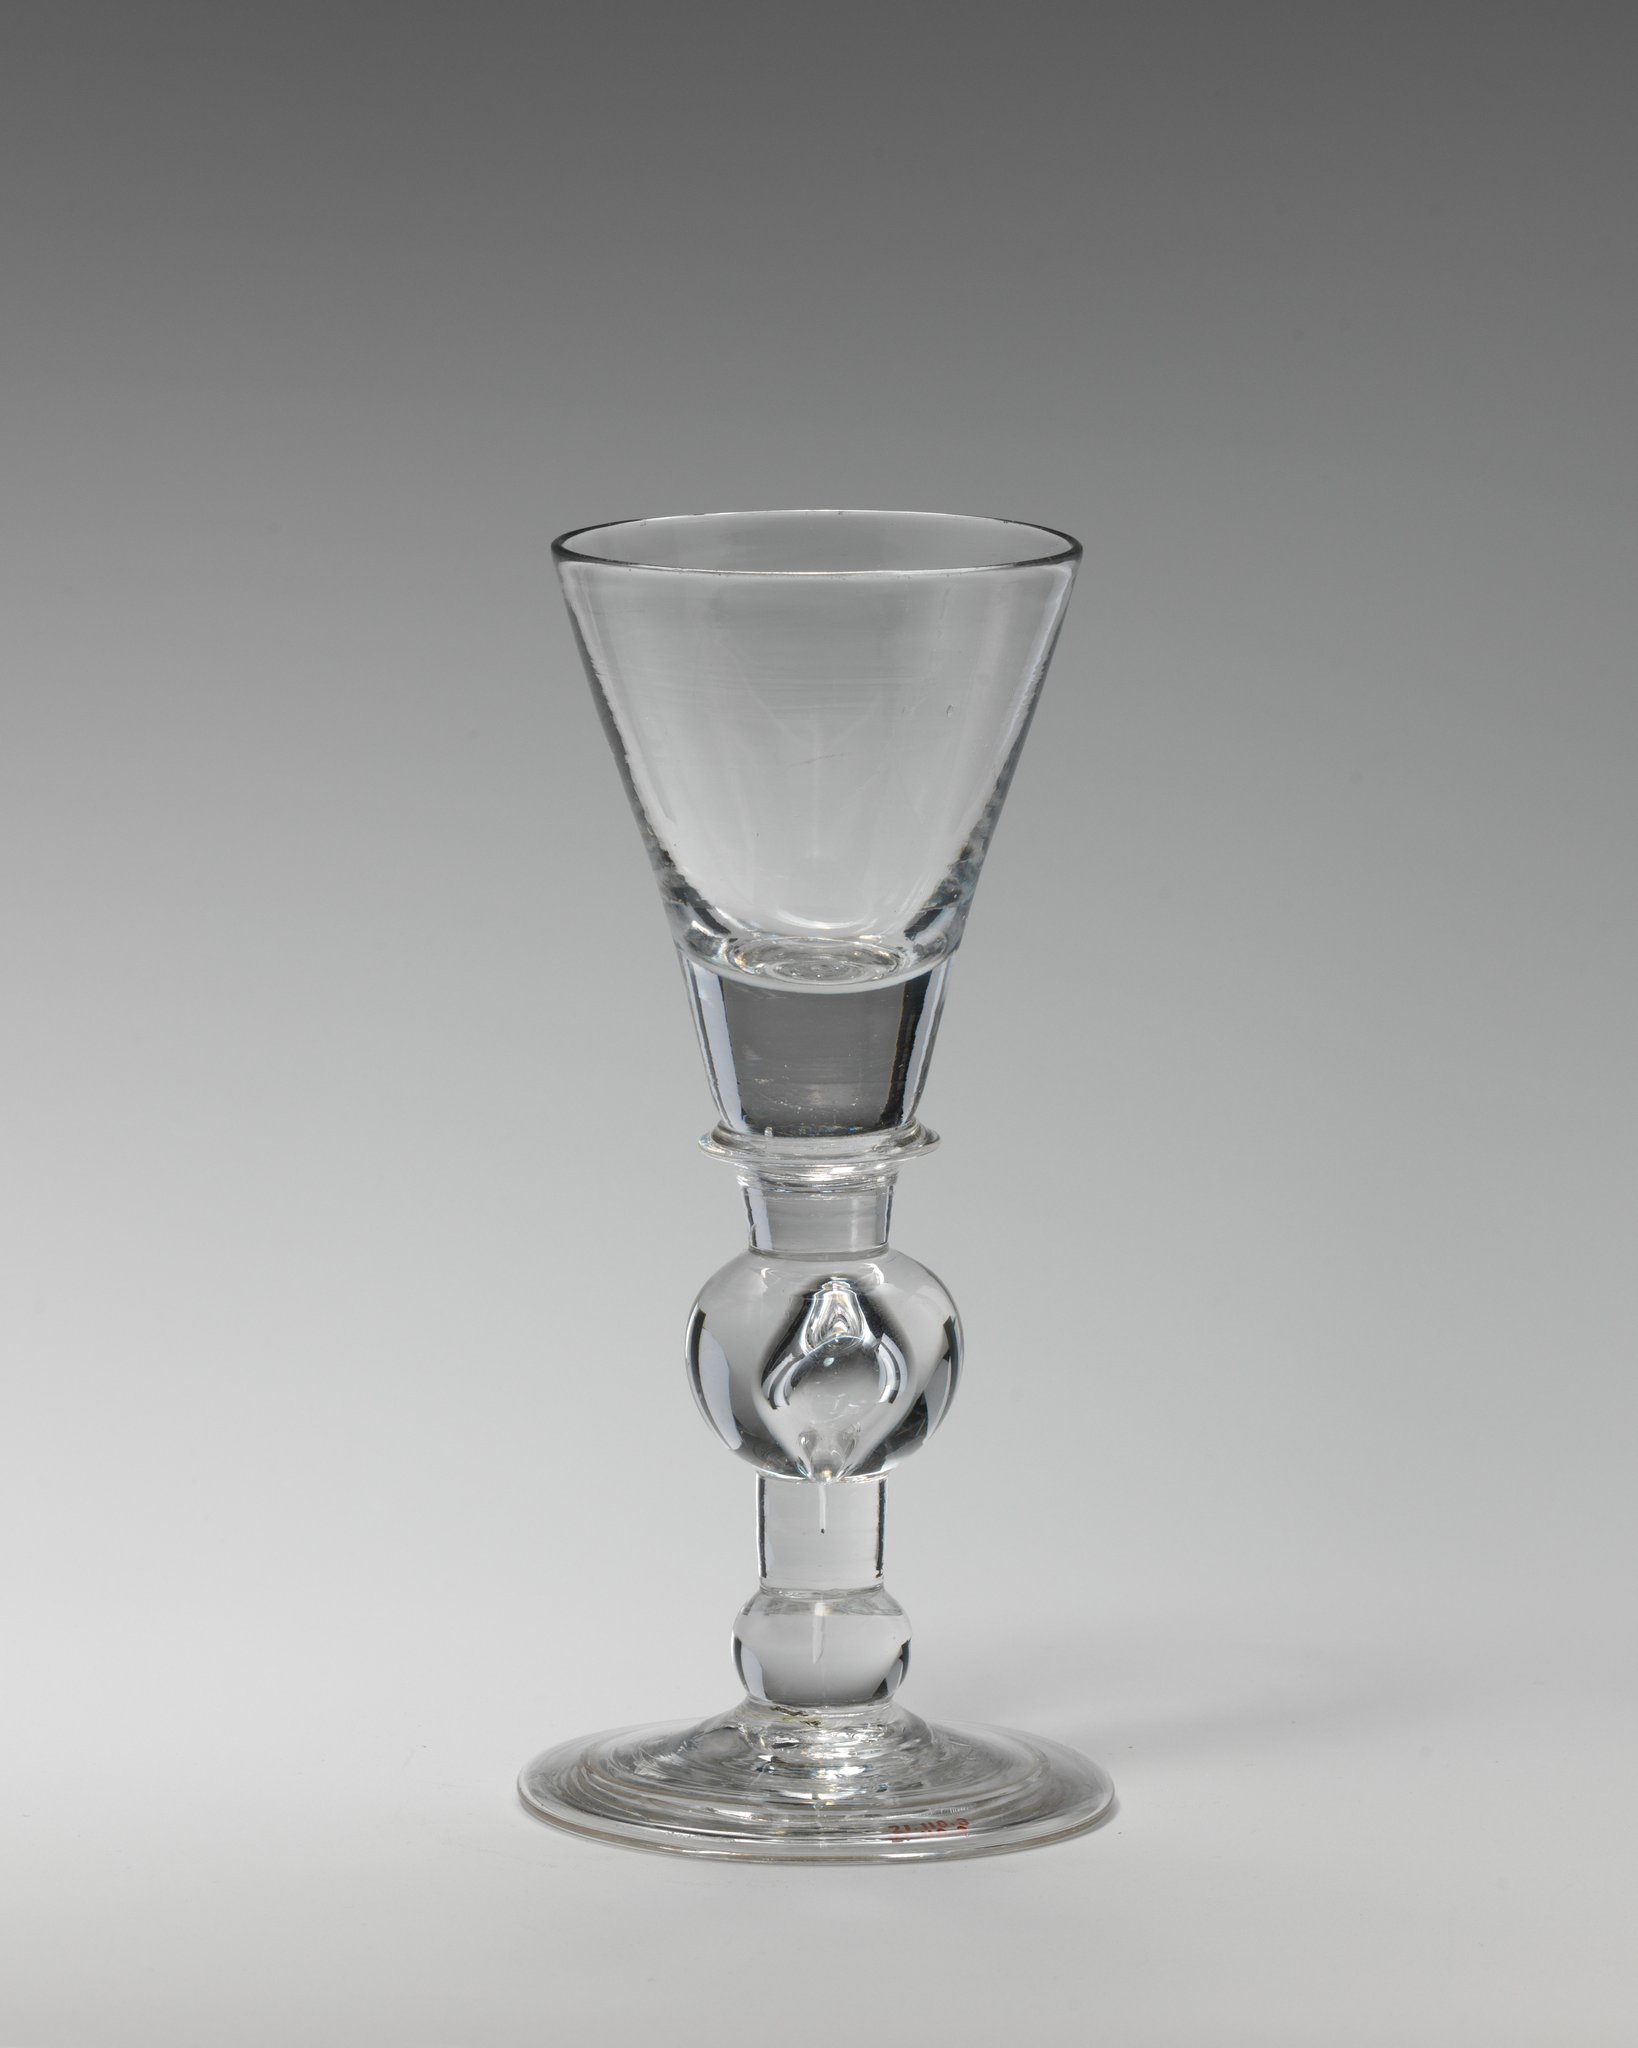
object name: wineglass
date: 1740-1800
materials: glass